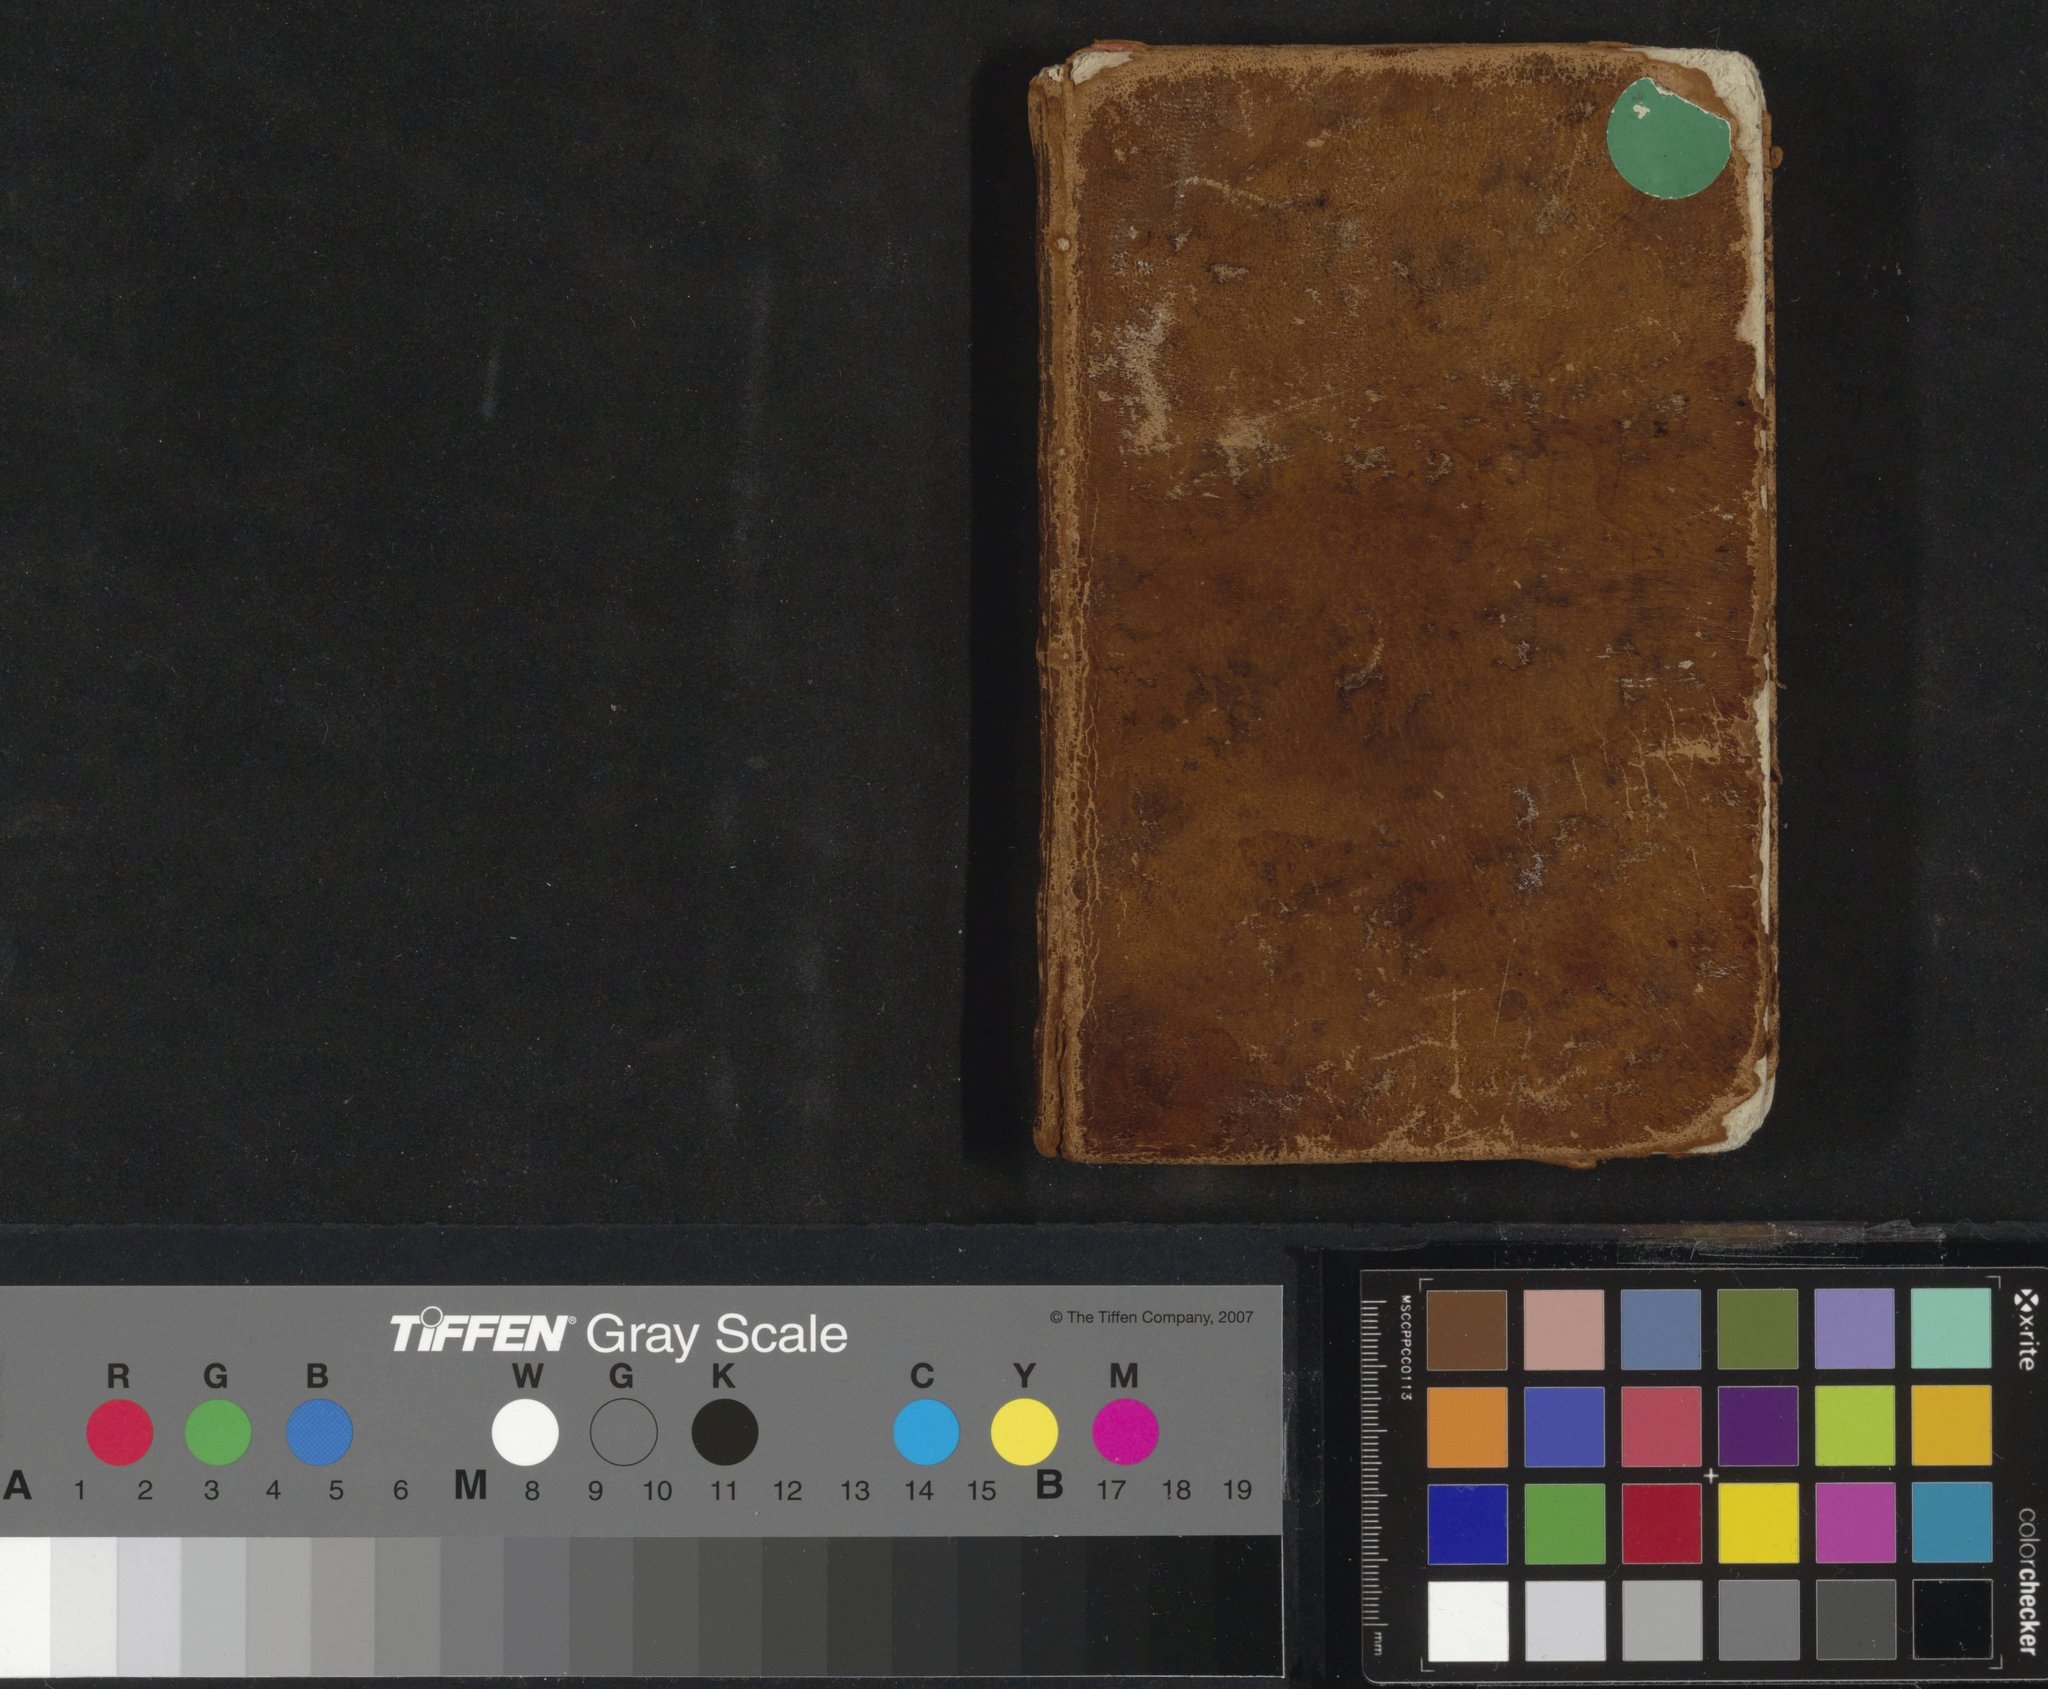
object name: sketchbook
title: Schetsboek met 83 bladen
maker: jean honoré fragonard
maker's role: draughtsman, painter, print maker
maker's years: 1732-1806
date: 1765-1775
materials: cardboard, chalk, leather, paper, pencil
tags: trees, sitting figure, landscapes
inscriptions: label: ‘MADE/ IN/ FRANCE’, label: ‘D.W./ 1055’, label: ‘259’, number: ‘D.W/ 1055’, stamp: ‘D[...]ANES/ EXPOSITION/ PARIS’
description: De volgende bladen uit het schetsboek zijn blanco: 1(V), 4, 6(V) t/m 8(V), 9 t/m 11, 12(V) t/m 14(V), 15, 16, 17(V), 18, 19, 20(V), 21(V), 22 t/m 26, 27(V), 28, 29(V), 30(R), 31(V), 32(V), 33, 35 t/m 37, 38(V), 39, 42(V), 43 t/m 51(R), 52(R), 53(V), 54 t/m 56(R), 57(R), 59(R), 61(R), 62(R), 63(R), 66(R), 68(R) t/m 70(R), 72(R), 76(R), 77(R), 79(R) en 82(R).